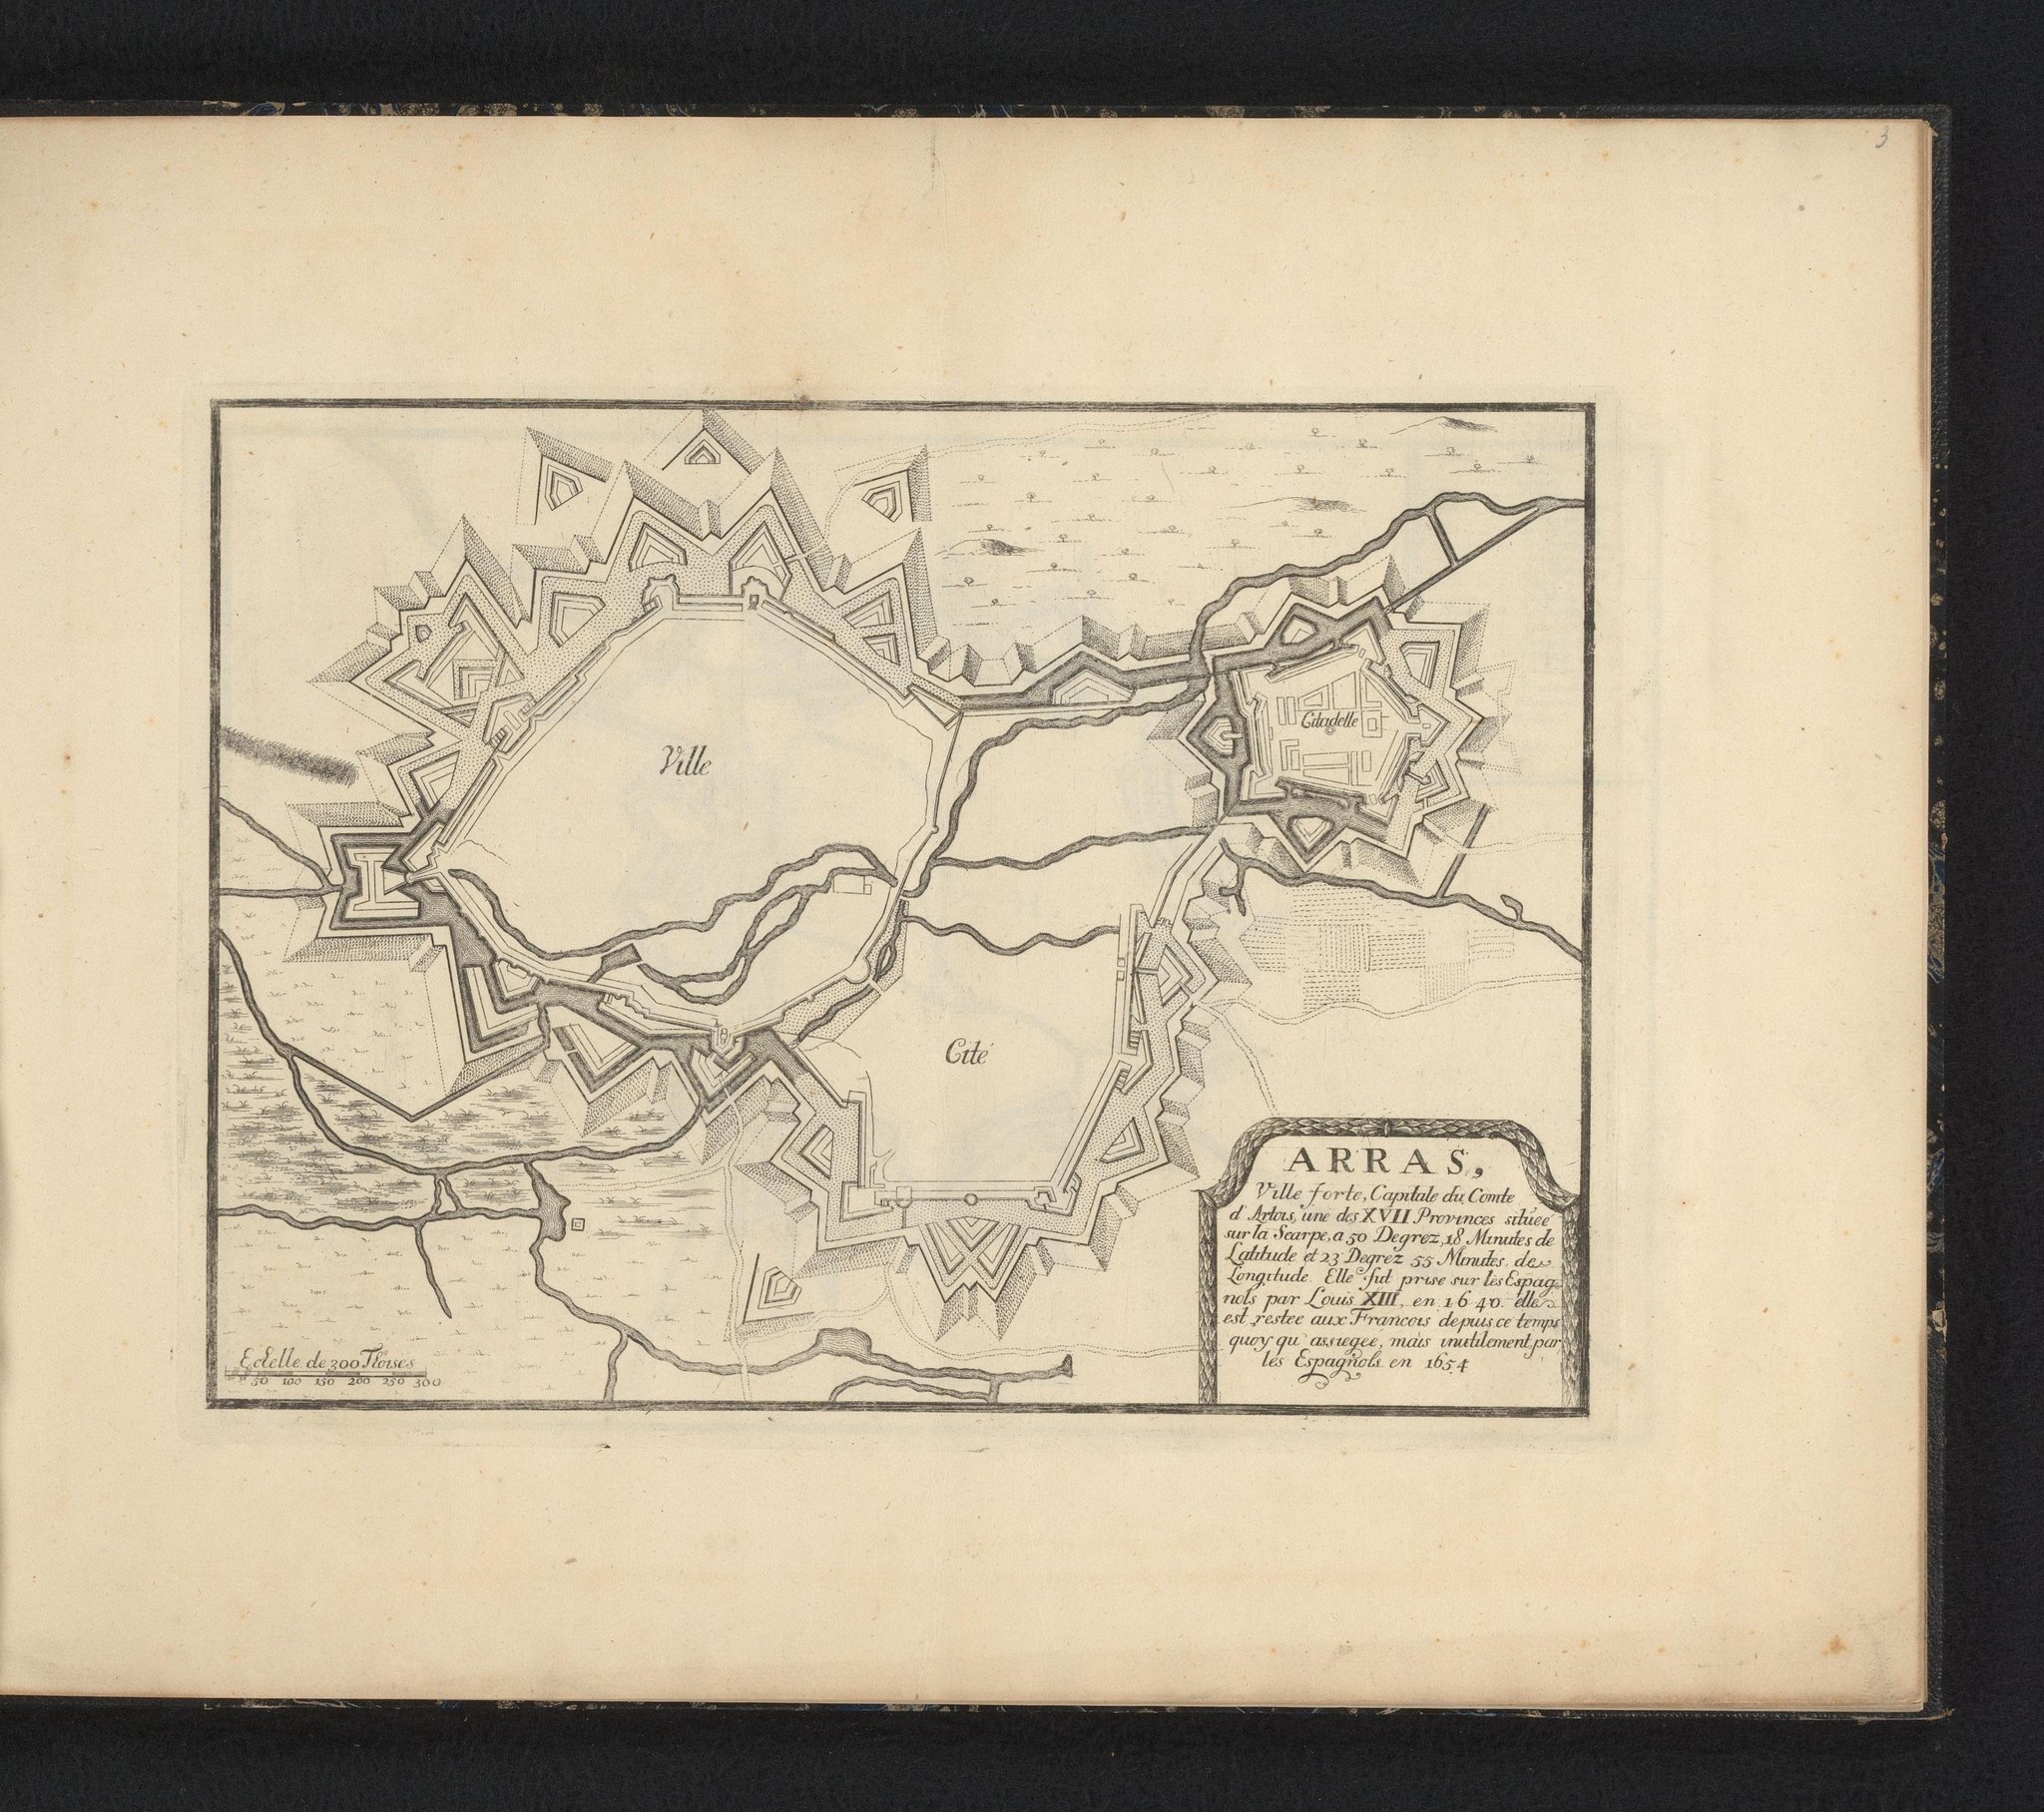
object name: print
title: Plattegrond van Arras, ca. 1693-1696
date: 1693-1696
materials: paper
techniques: etching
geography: france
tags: fortress, maps of cities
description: Plattegrond van de versterkingen om de Zuid-Nederlandse stad Arras (Atrecht). Maakt deel uit van het eerste deel van het prentwerk: Le Theatre de la Guerre, dans les Pays-Bas, uitgegeven in 1696. Dit deel bevat 25 platen met plannen (afkomstig van Sébastien Le Prestre, Seigneur de Vauban) van vermaarde sterke steden en vestingen in de Negenjarige Oorlog in de Nederlanden. Titel en opschriften in het Frans.